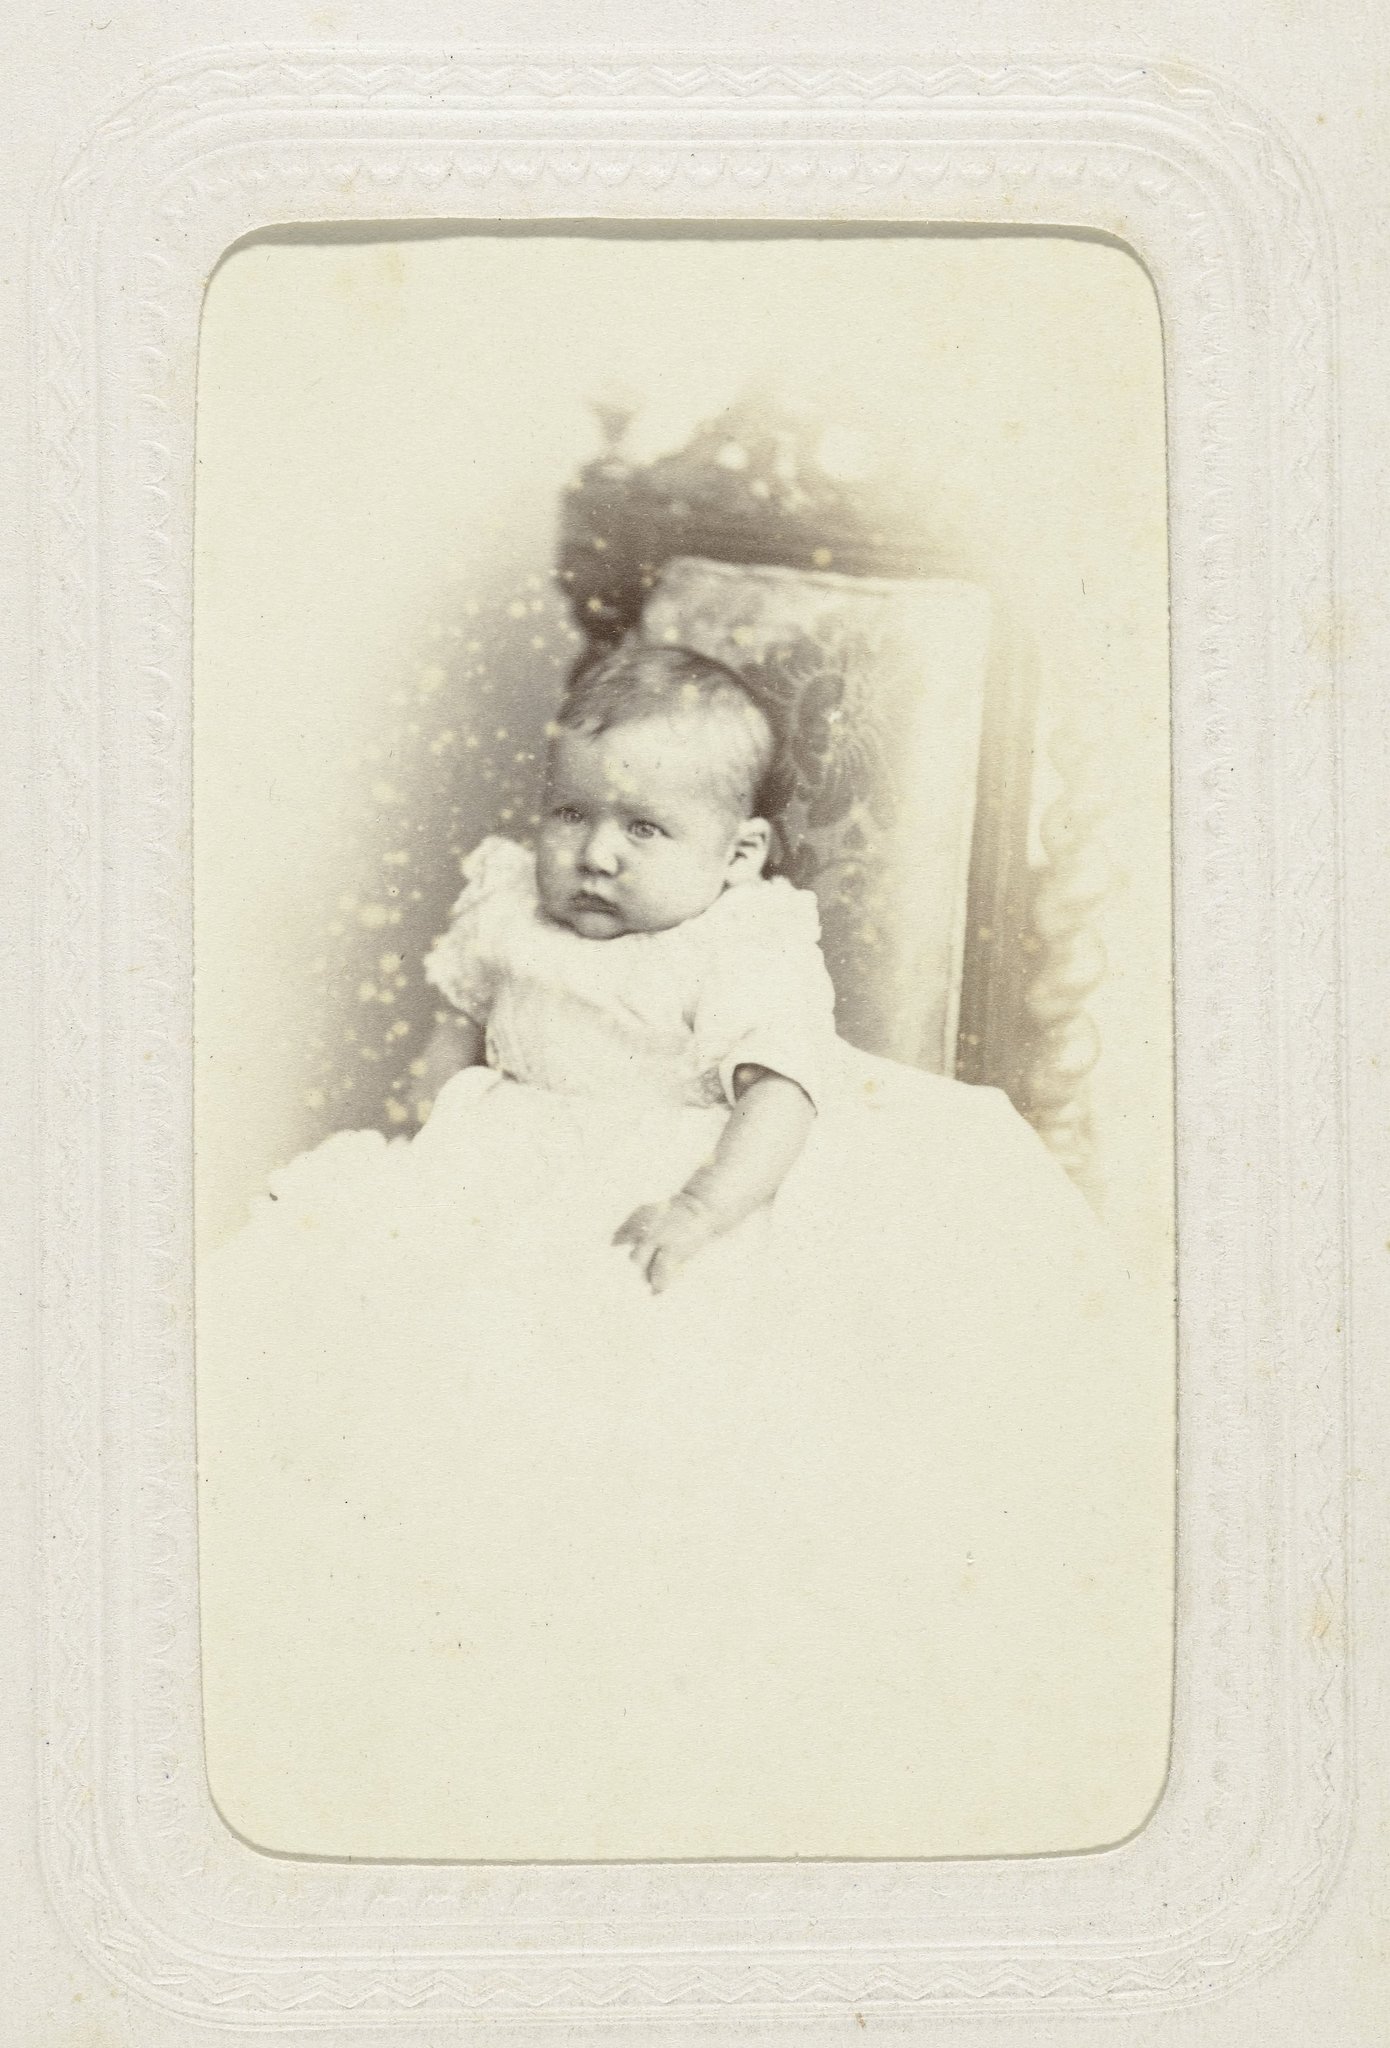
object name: carte de visite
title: Studioportret van een baby in een witte jurk op een stoel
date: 1863-1870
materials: cardboard, paper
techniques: albumen print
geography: amsterdam